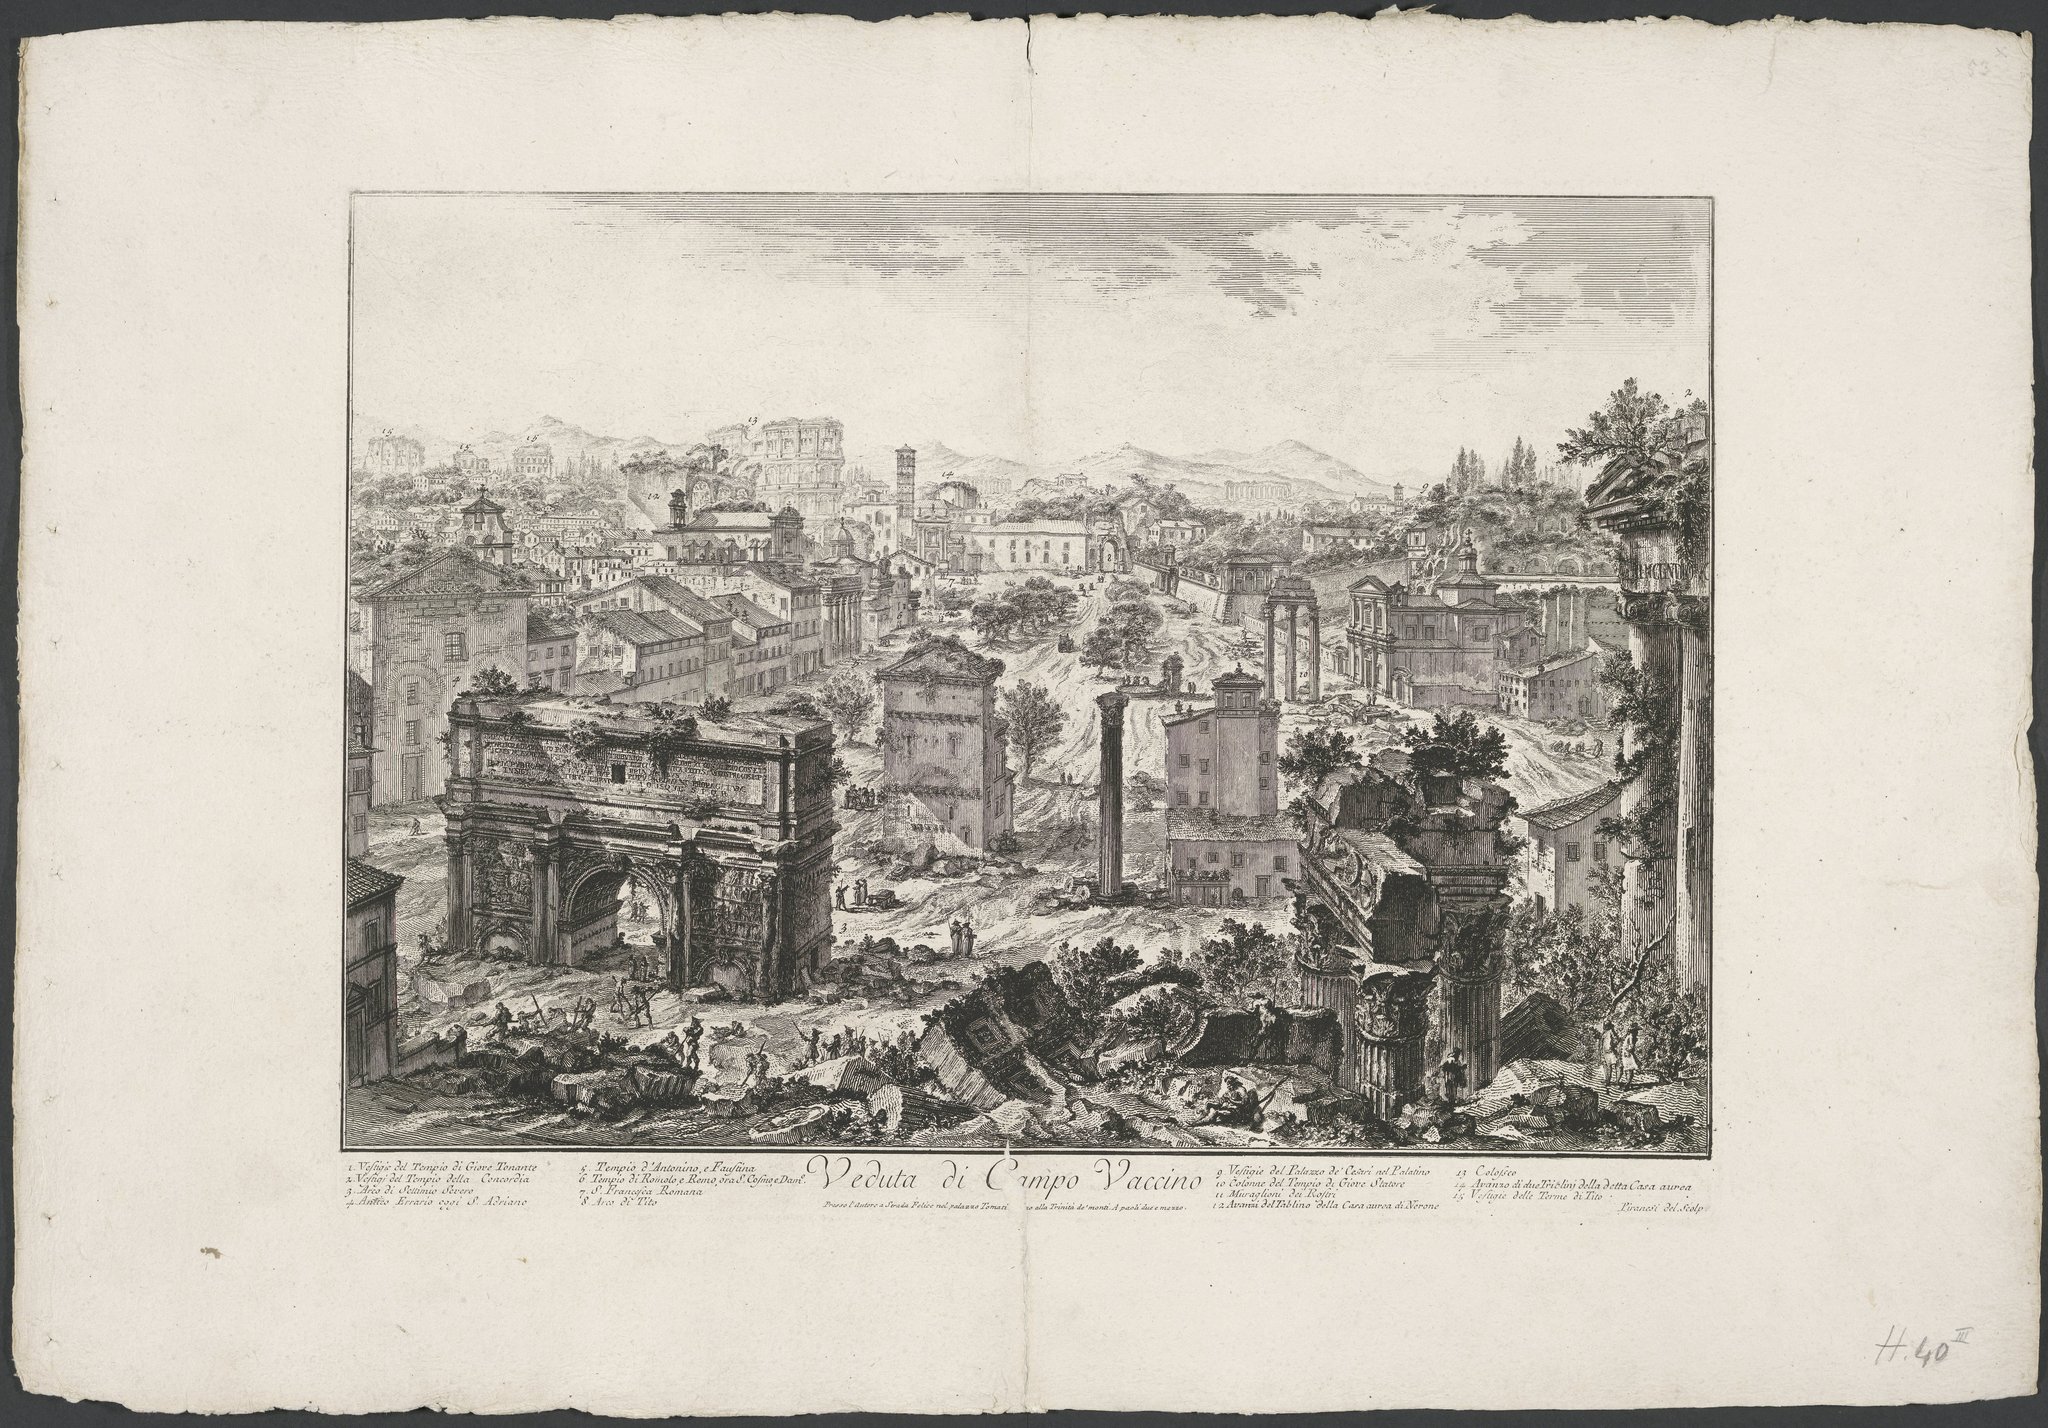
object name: print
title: Forum Romanum te Rome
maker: giovanni battista piranesi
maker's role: designer, draughtsman, print maker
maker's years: 1720-1778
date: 1748-1778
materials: paper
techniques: etching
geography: rome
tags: ruin of a building ~ architecture, triumphal arch, landscape with ruins, temple, shrine ~ roman religion, rome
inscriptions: collector's mark: Lugt 2228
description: Gezicht op het Forum Romanum te Rome. Op de voorgrond de Boog van Septimius Severus en de resten van de Tempio di Giove Statore. Op de achtergrond onder andere de Basilica van Maxentius en het Colosseum. Titel en verklarende lijst met nummers in ondermarge.